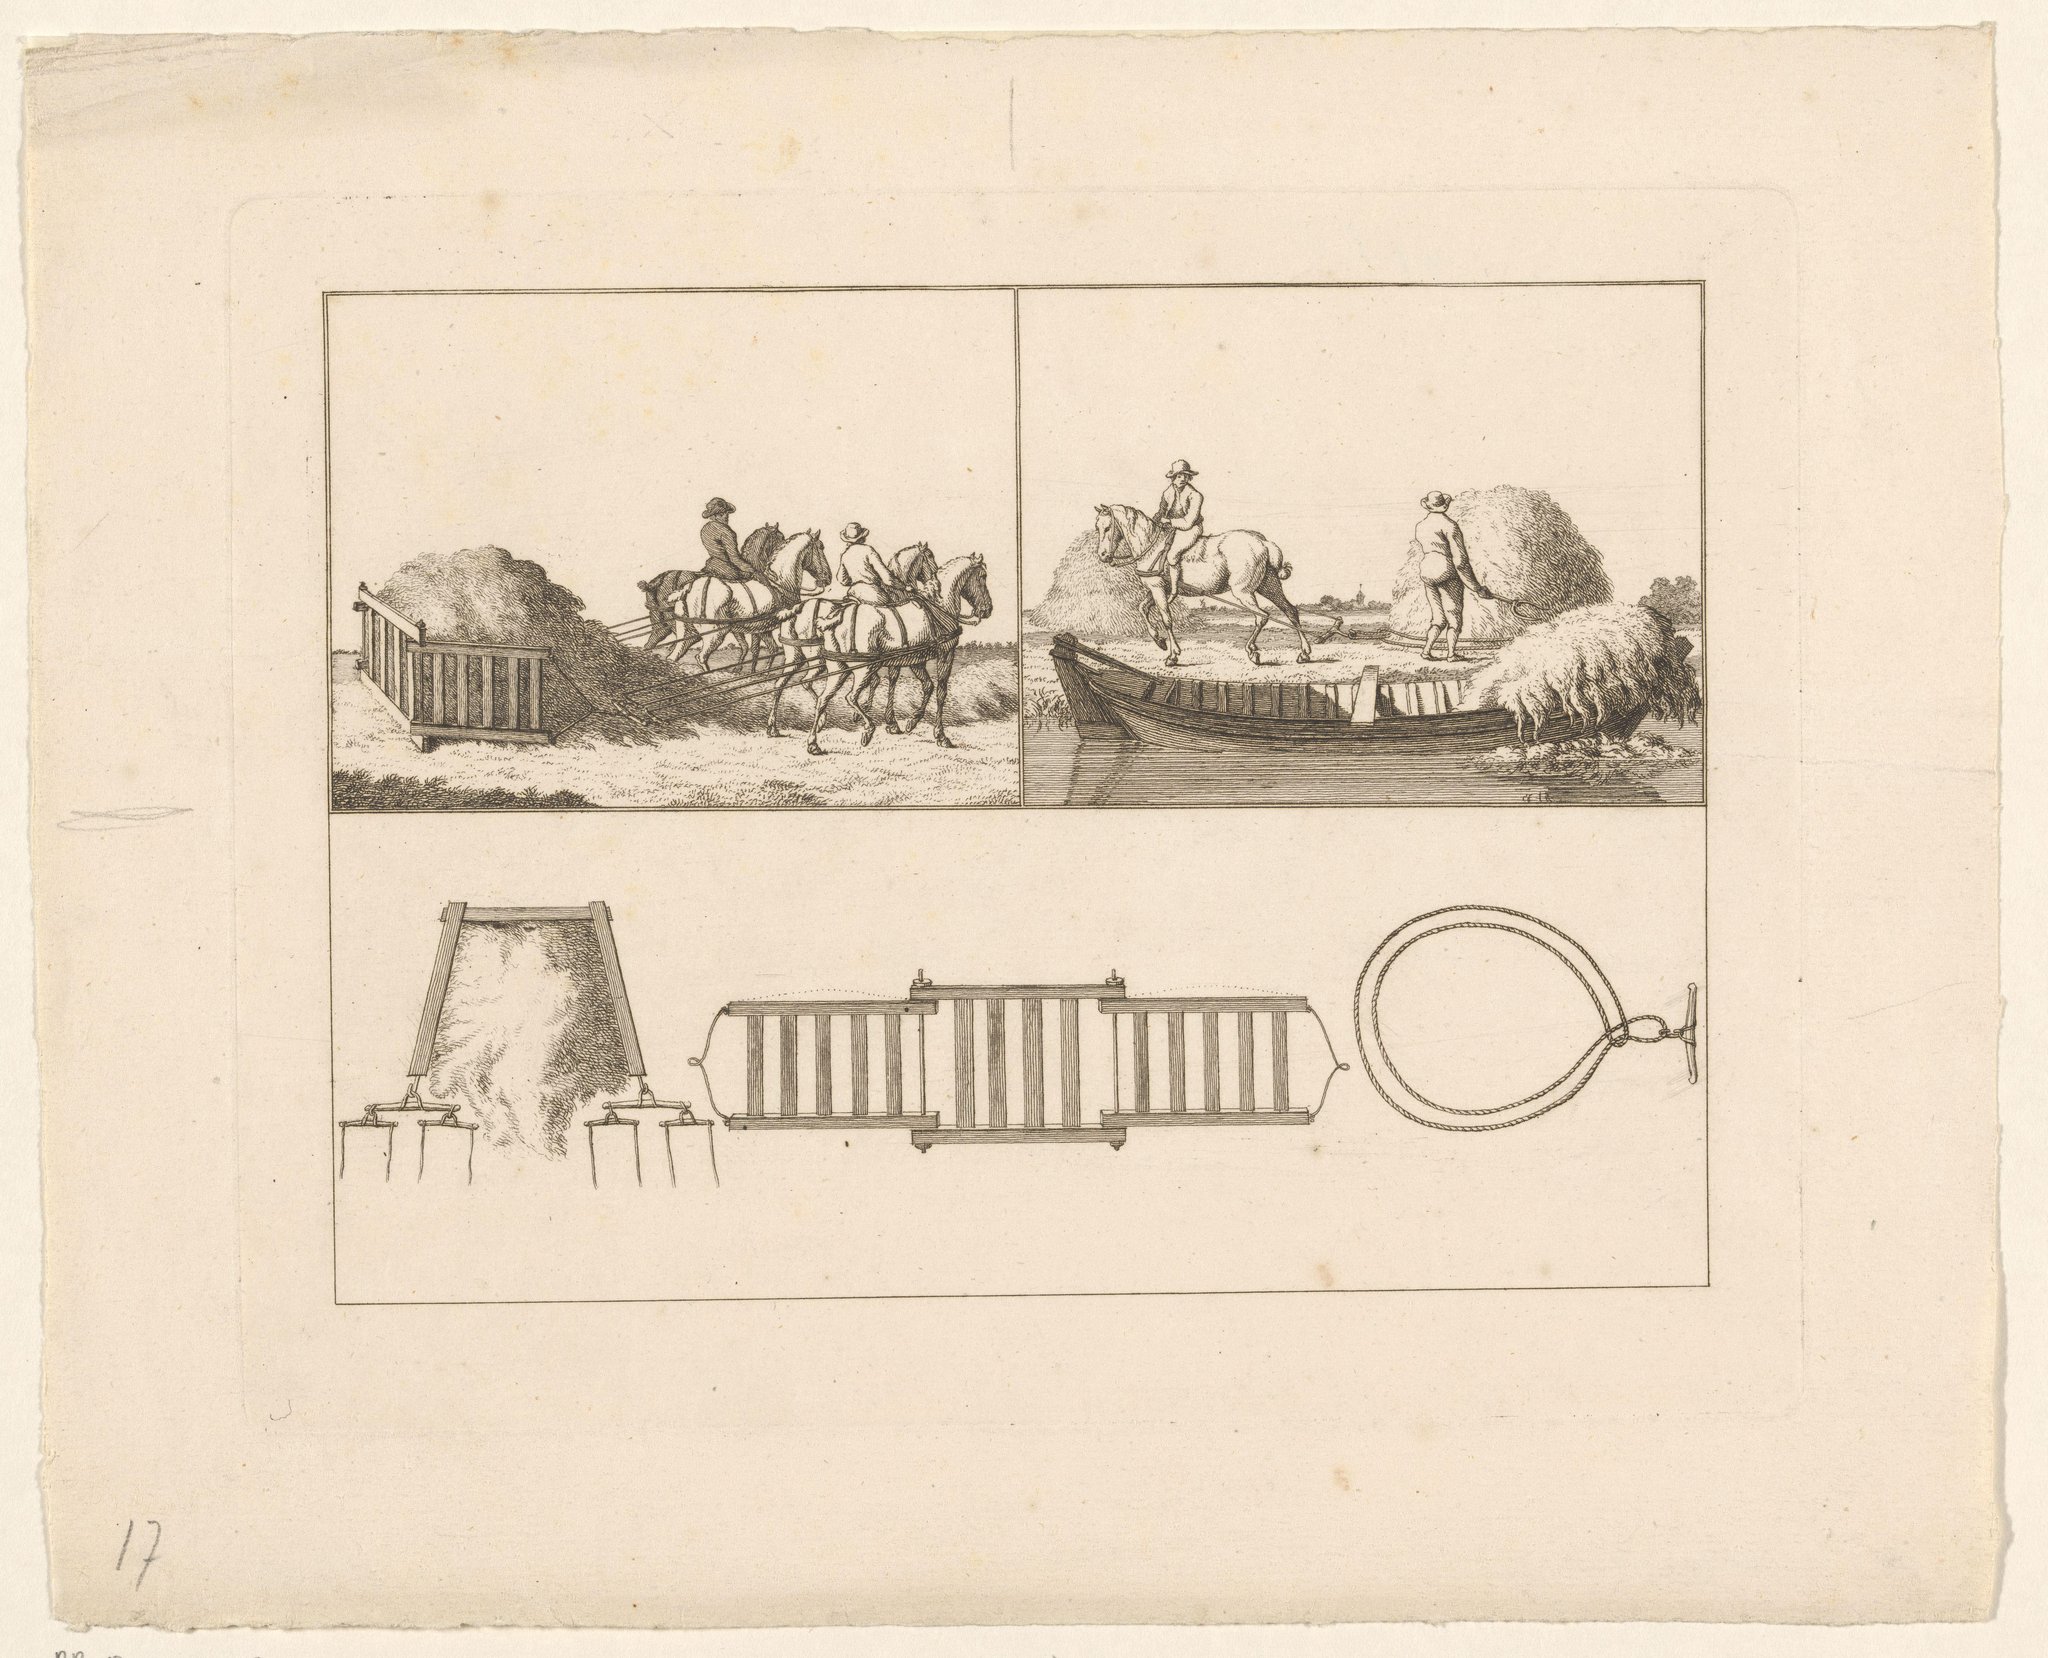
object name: print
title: Drie scènes met betrekking tot de landbouw, mogelijk het vervoeren van hooi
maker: Anonymous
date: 1700-1799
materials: paper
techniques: etching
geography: netherlands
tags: agricultural products and by-products: hay, transporting ~ harvest, agricultural implements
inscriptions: collector's mark: Lugt 2228, watermark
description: Maakt mogelijk deel uit van een onbekende serie over landbouw en landbouwwerktuigen.